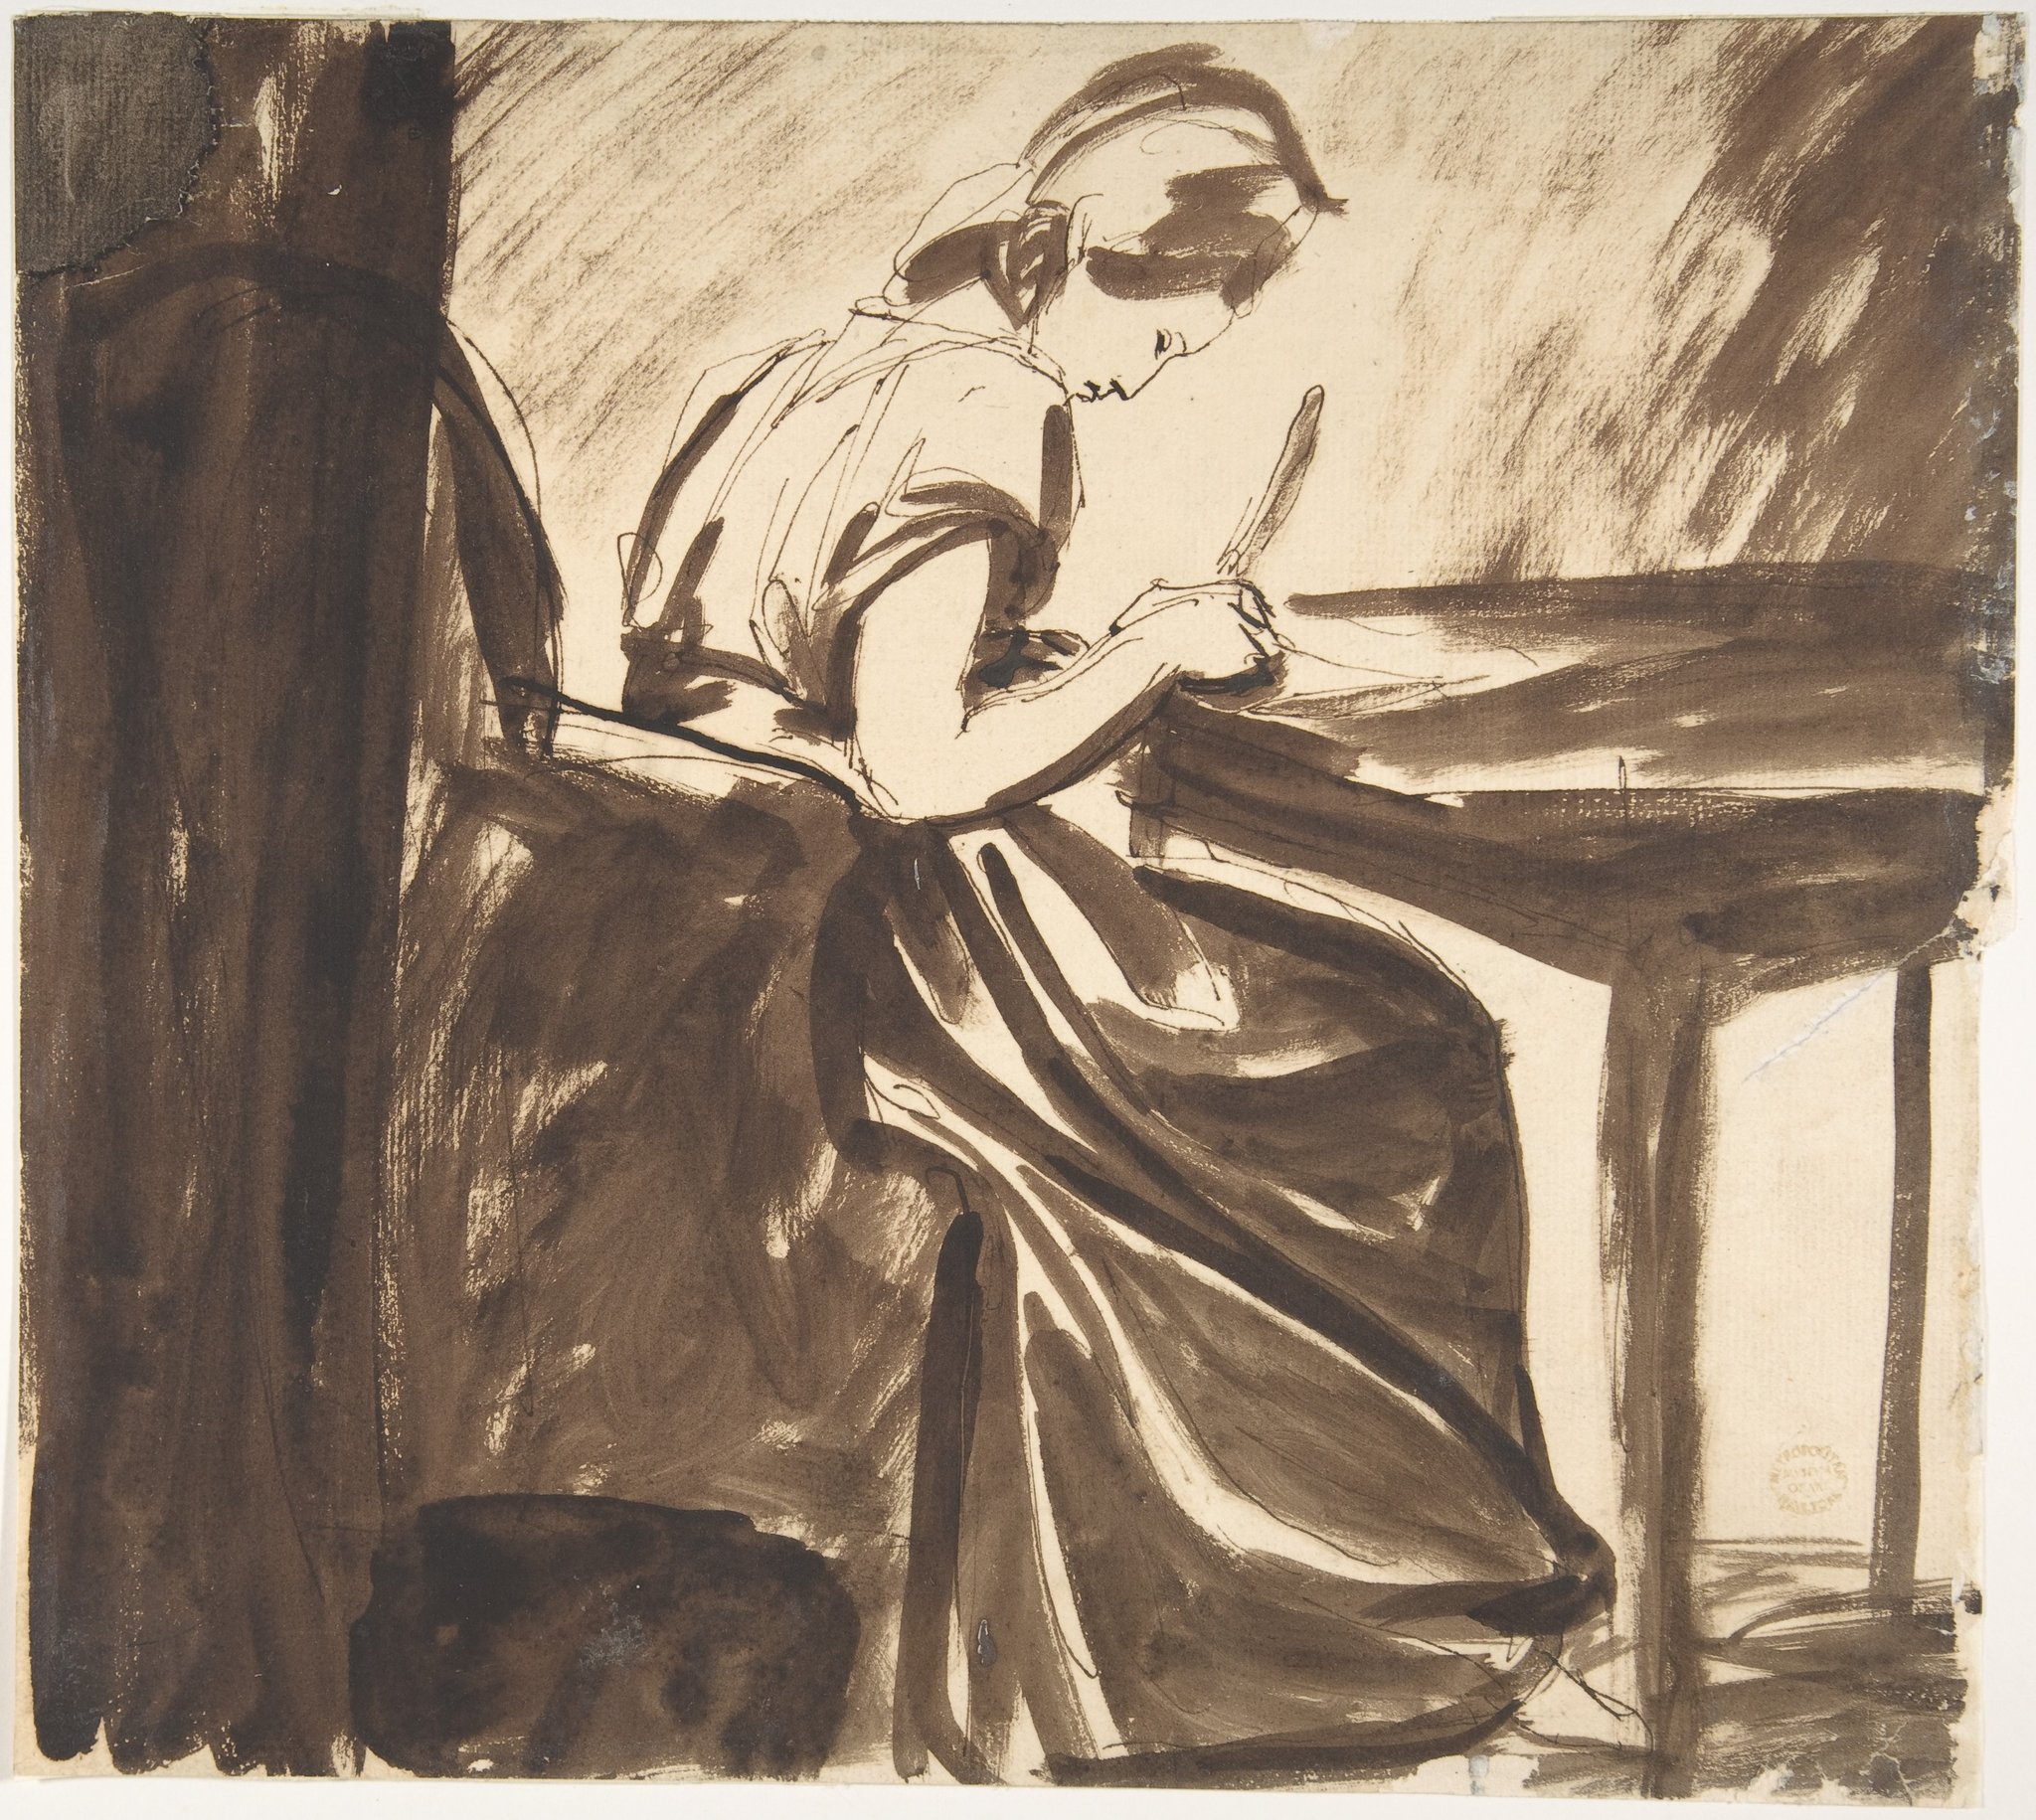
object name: drawing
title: Lady Seated at a Table (recto); Dancing Figures (verso)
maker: george romney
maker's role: artist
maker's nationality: british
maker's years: 1734-1802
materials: chalk, ink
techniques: brush, pen, wash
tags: women,dancing,writing